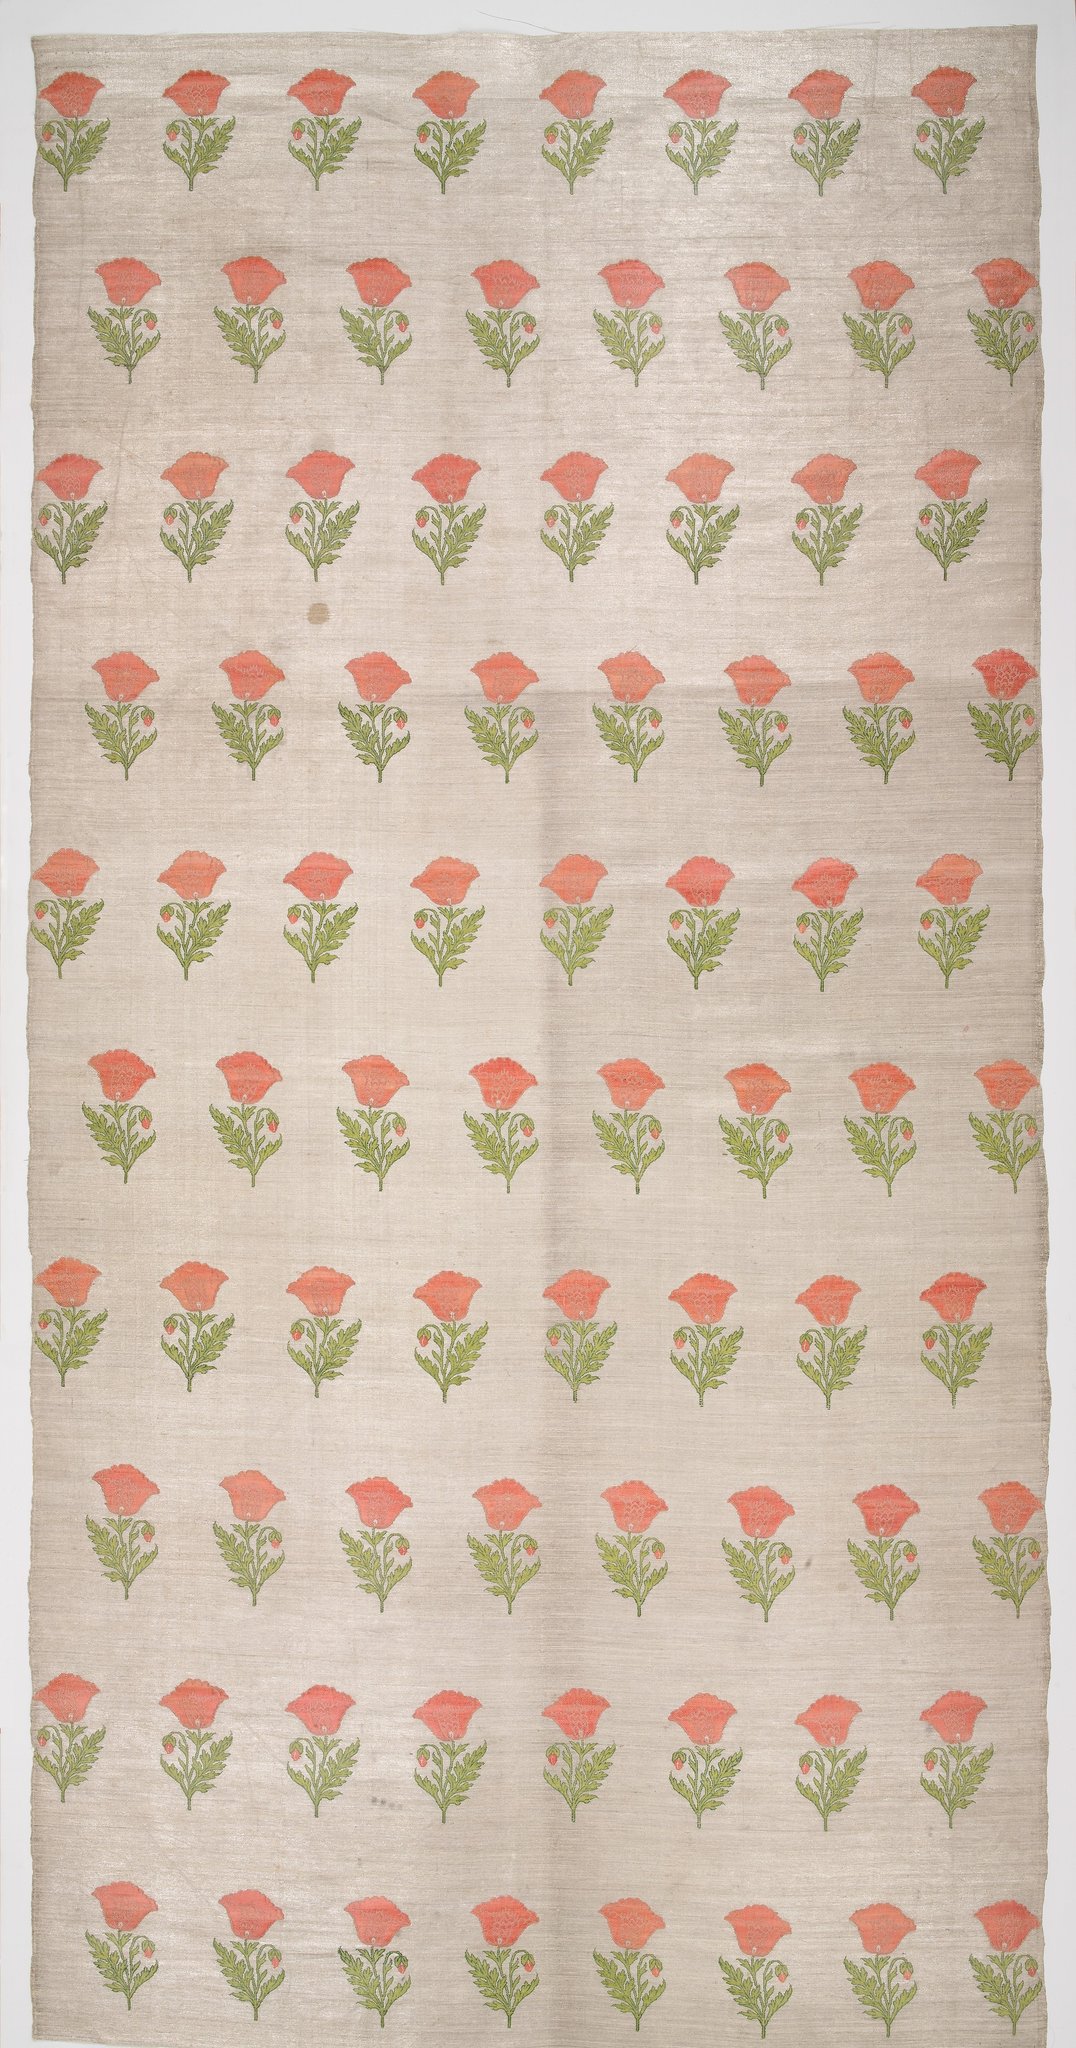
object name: textile fragment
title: Length of Fabric for Clothing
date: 1701-1800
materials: metal thread, silk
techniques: brocade, weave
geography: india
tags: flowers